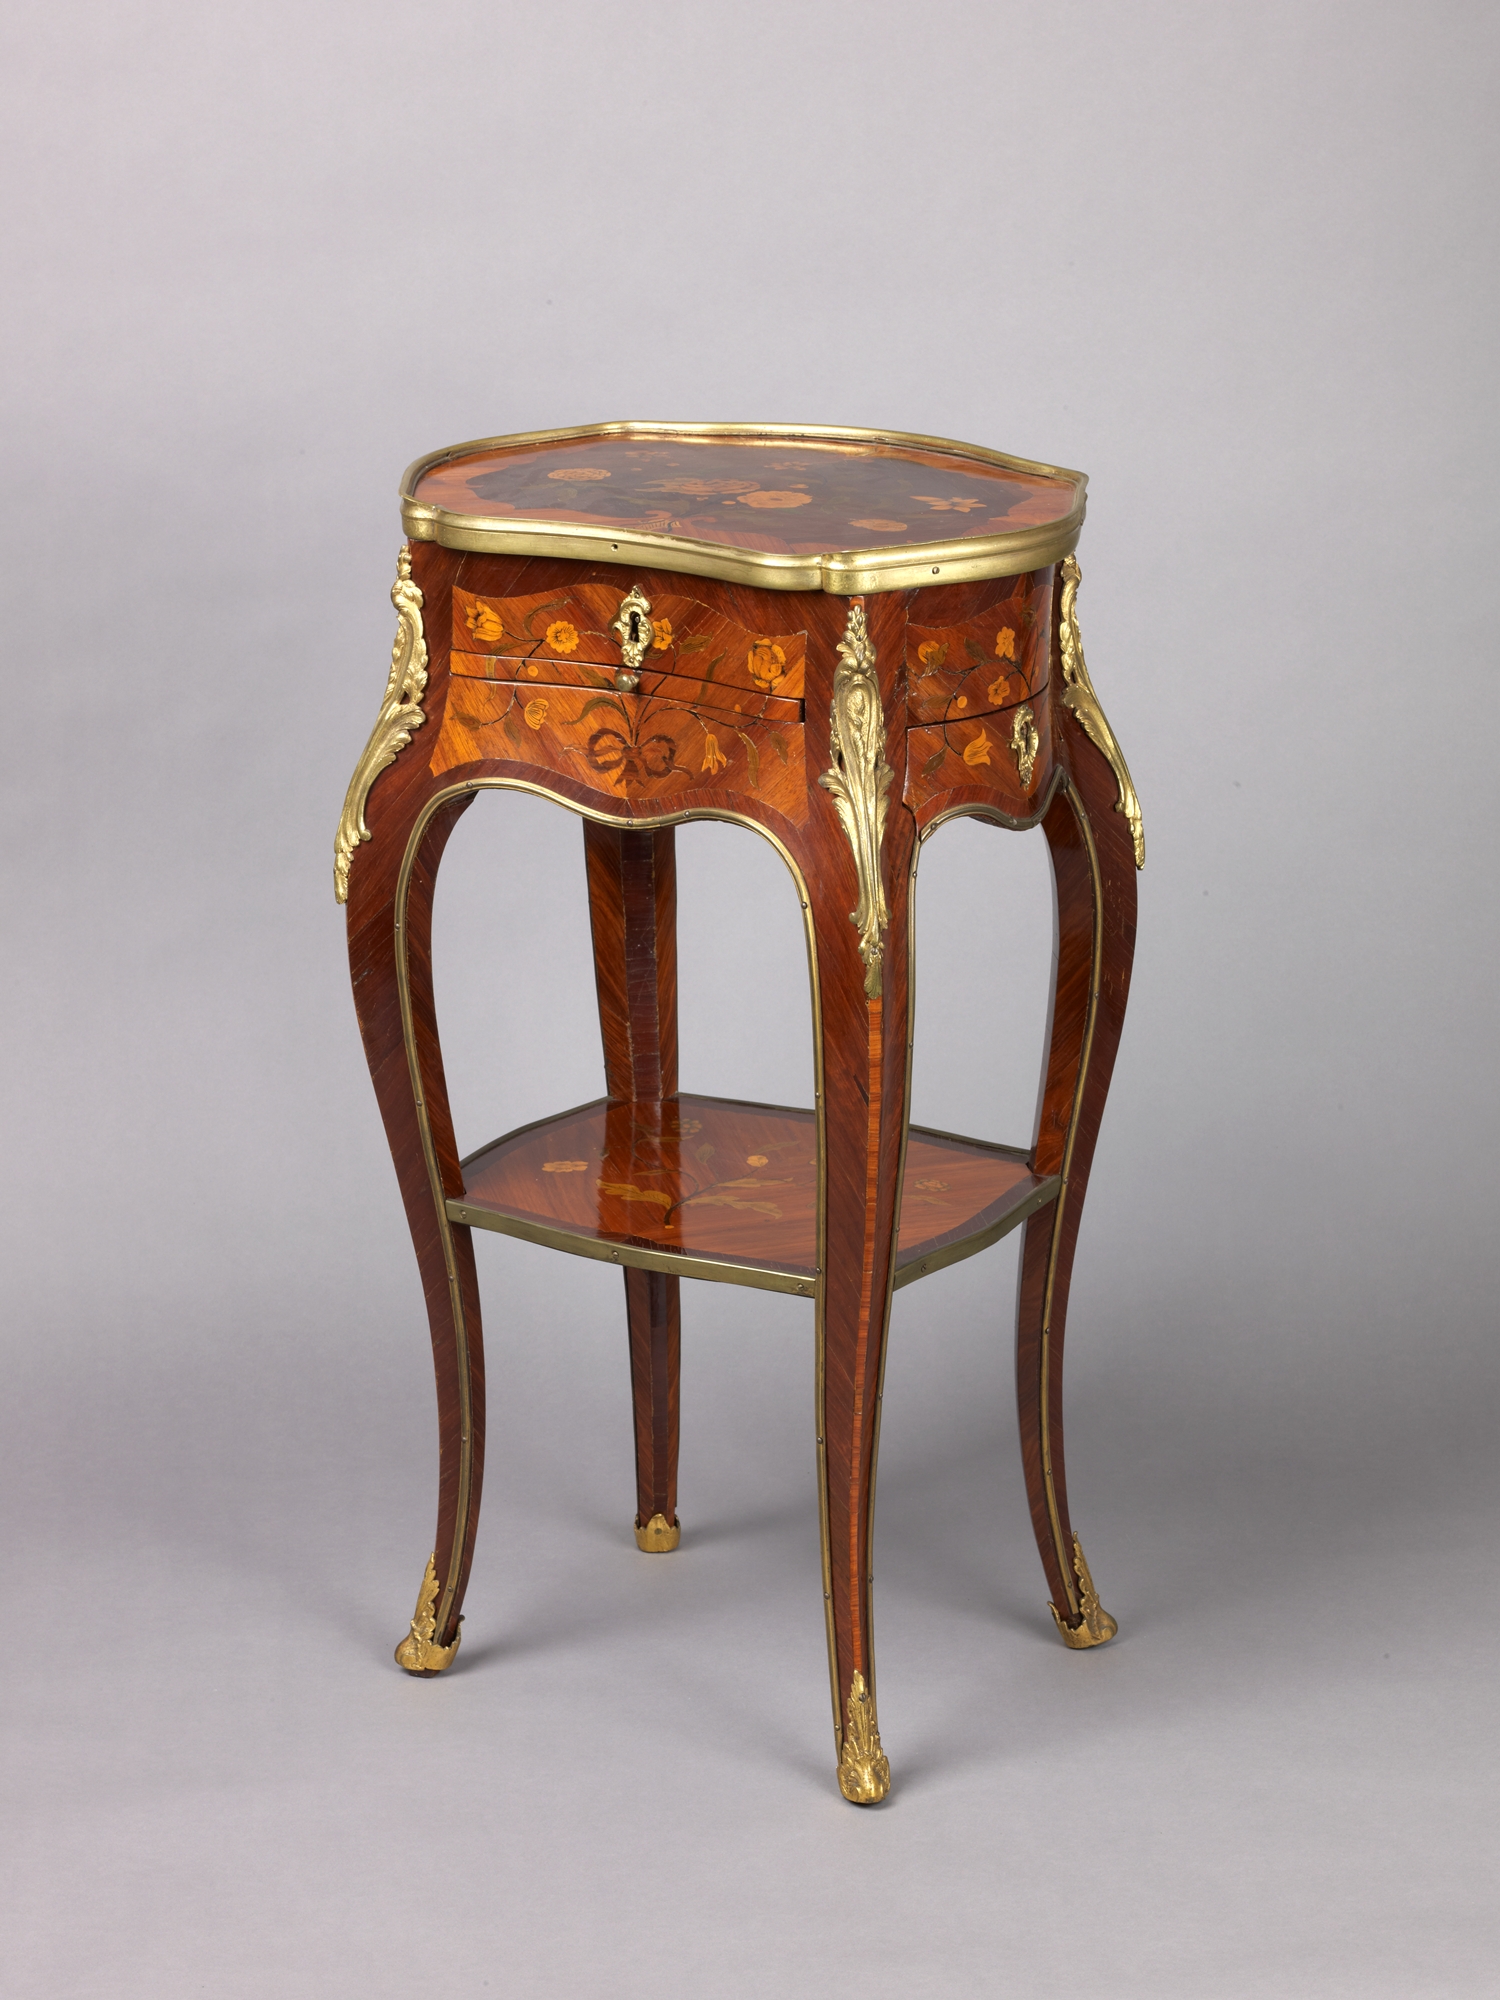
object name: table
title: Work and writing table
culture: french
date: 1750-1760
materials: brass, gilt bronze, gold, wood, leather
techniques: dyeing, engraving, stain, tooling, veneering